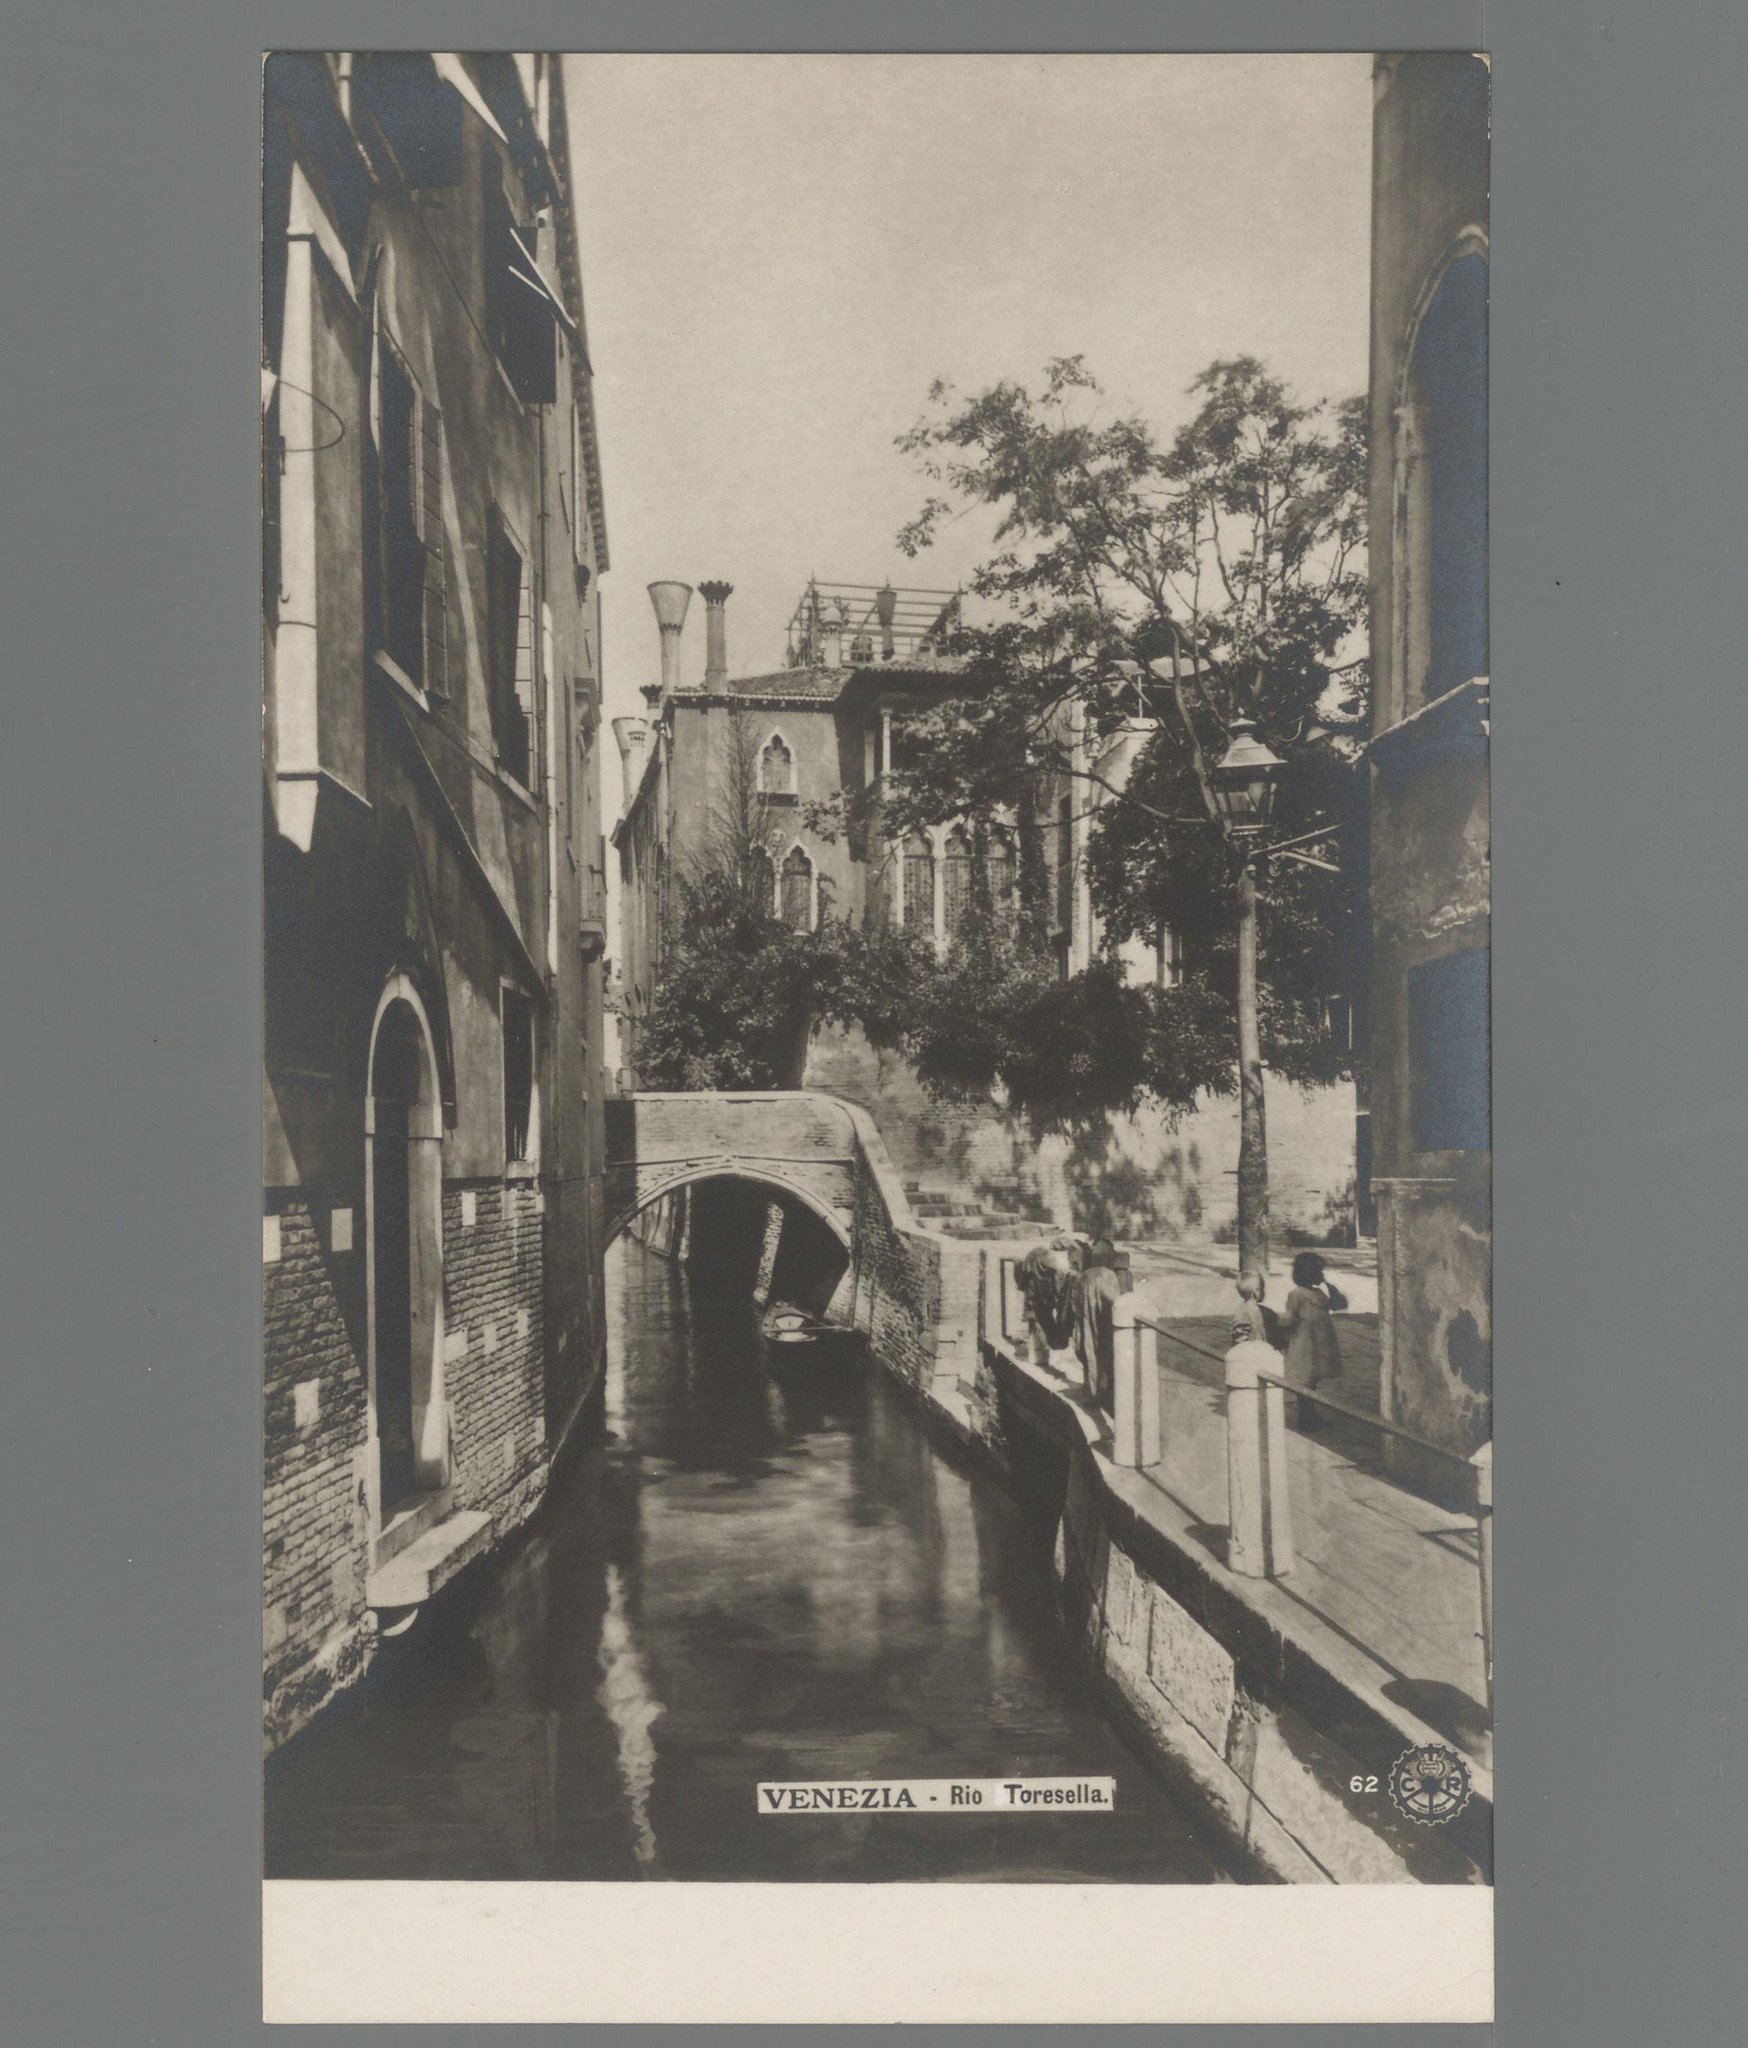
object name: ansichtkaart, prentbriefkaart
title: Venezia. Rio Toresella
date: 1906-1920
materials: photographic support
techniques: photography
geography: milan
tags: river, city-view, and landscape with man-made constructions (+ city(-scape) with figures, staffage), venice